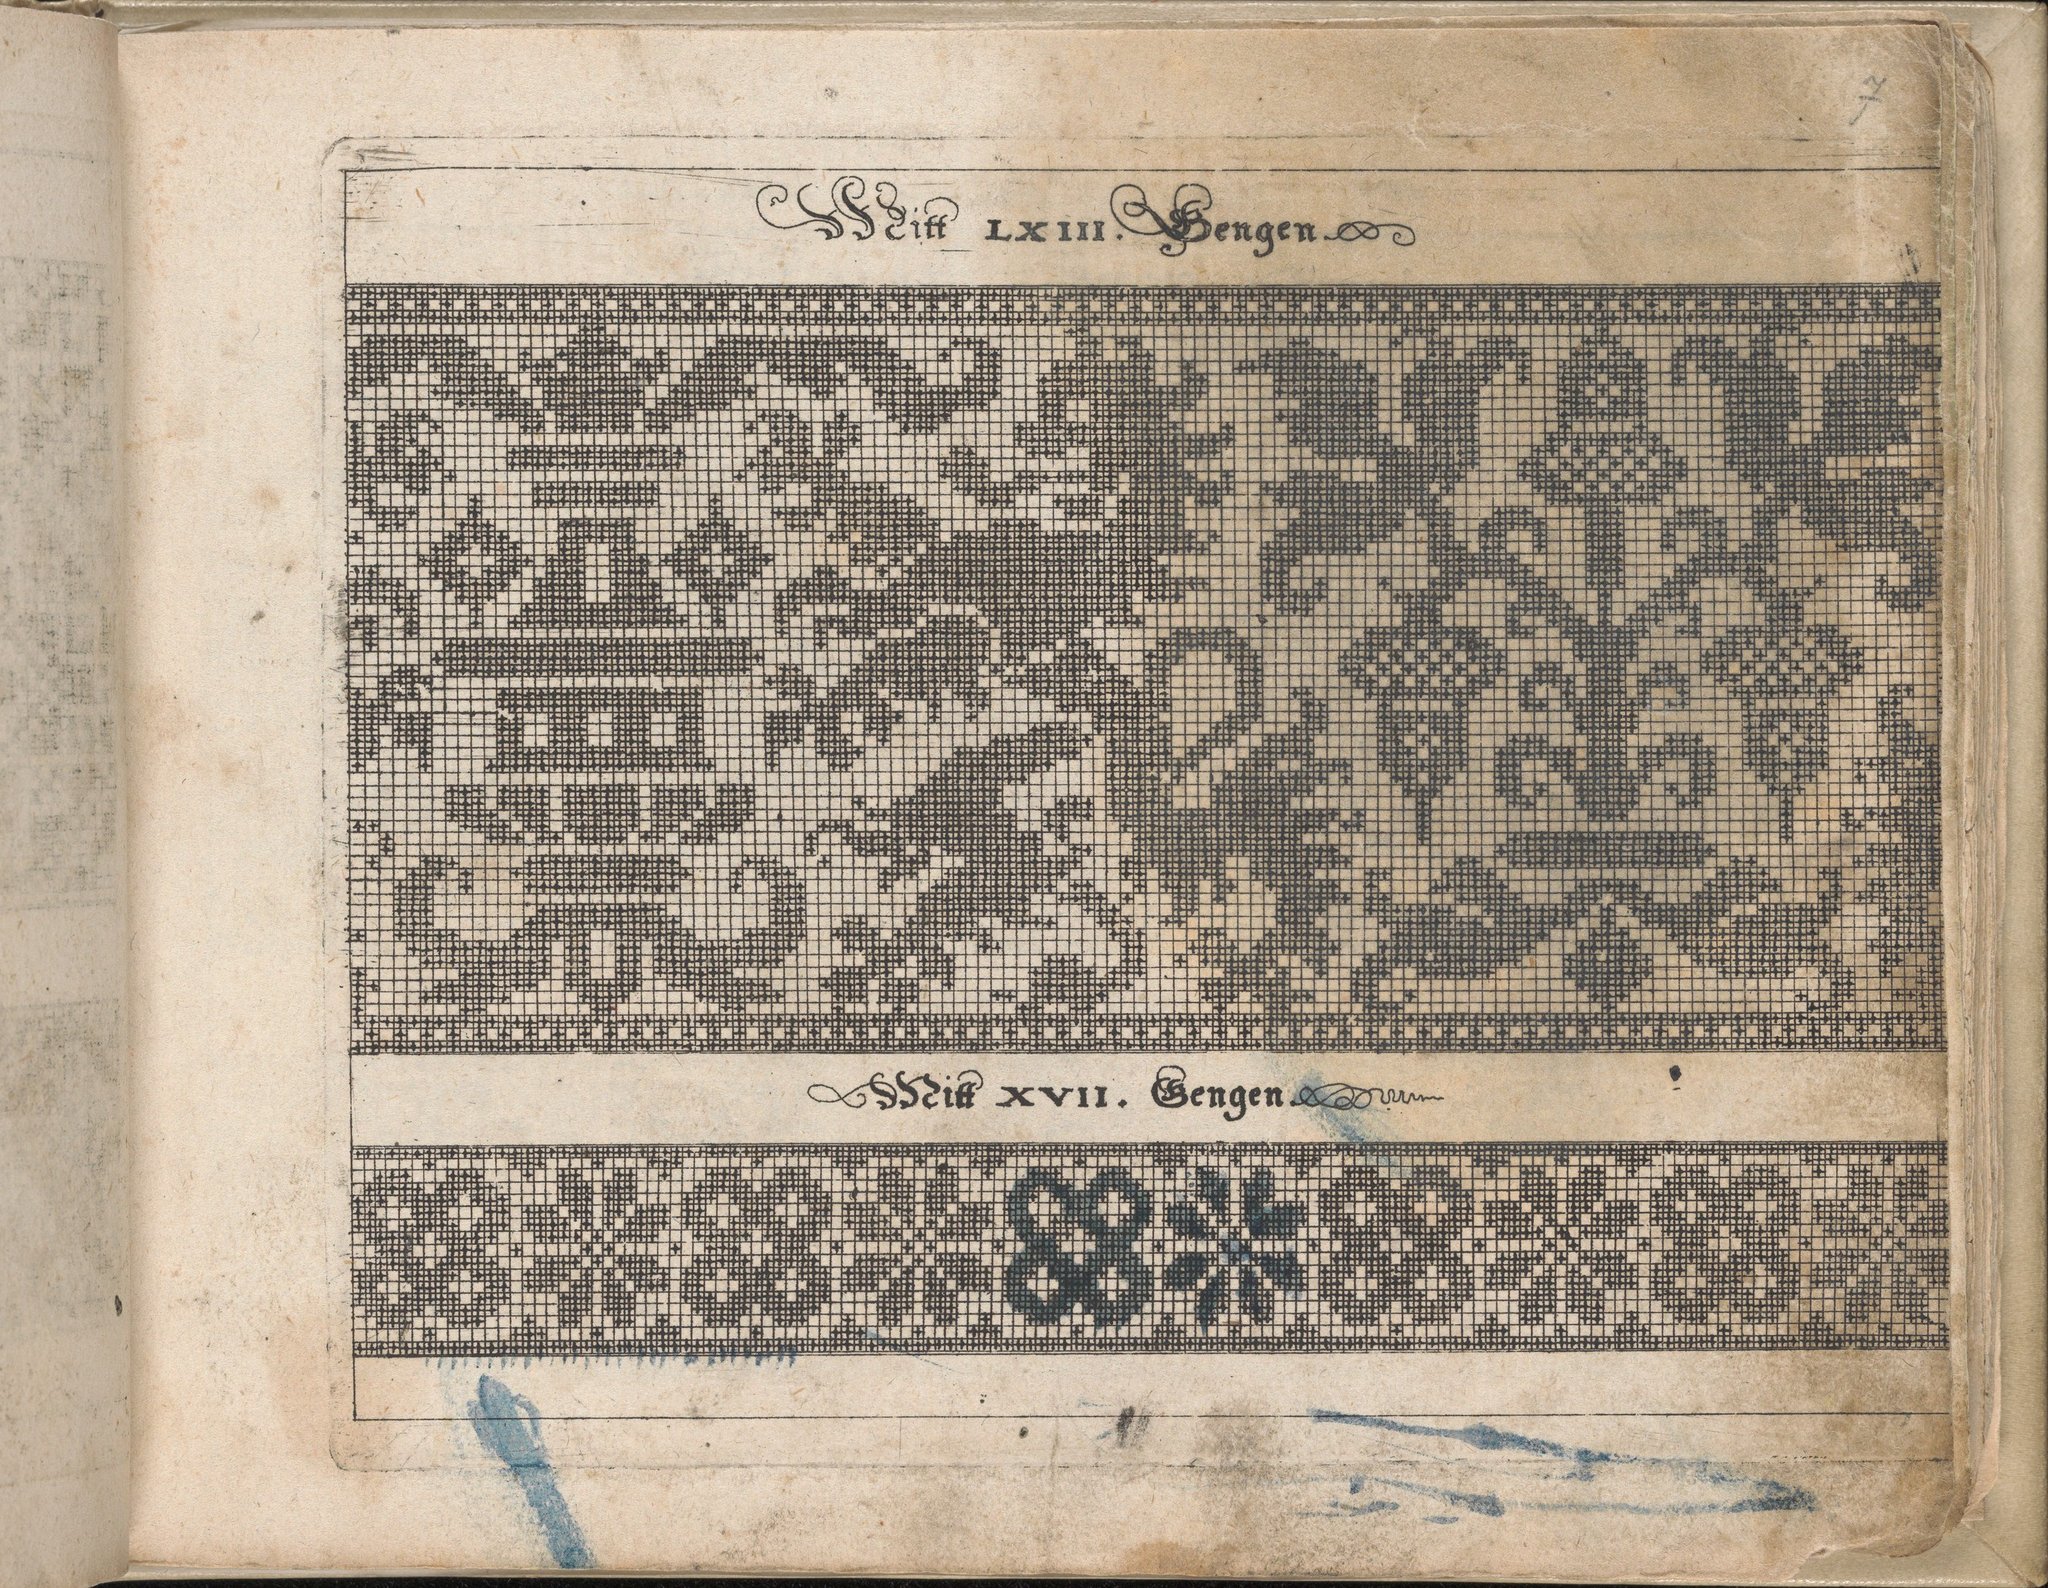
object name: book print ornament architecture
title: Schön Neues Modelbuch (Page 12 recto)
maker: johann sibmacher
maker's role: designer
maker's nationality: german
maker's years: 1590-1611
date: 1597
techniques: etching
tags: lions,flowers